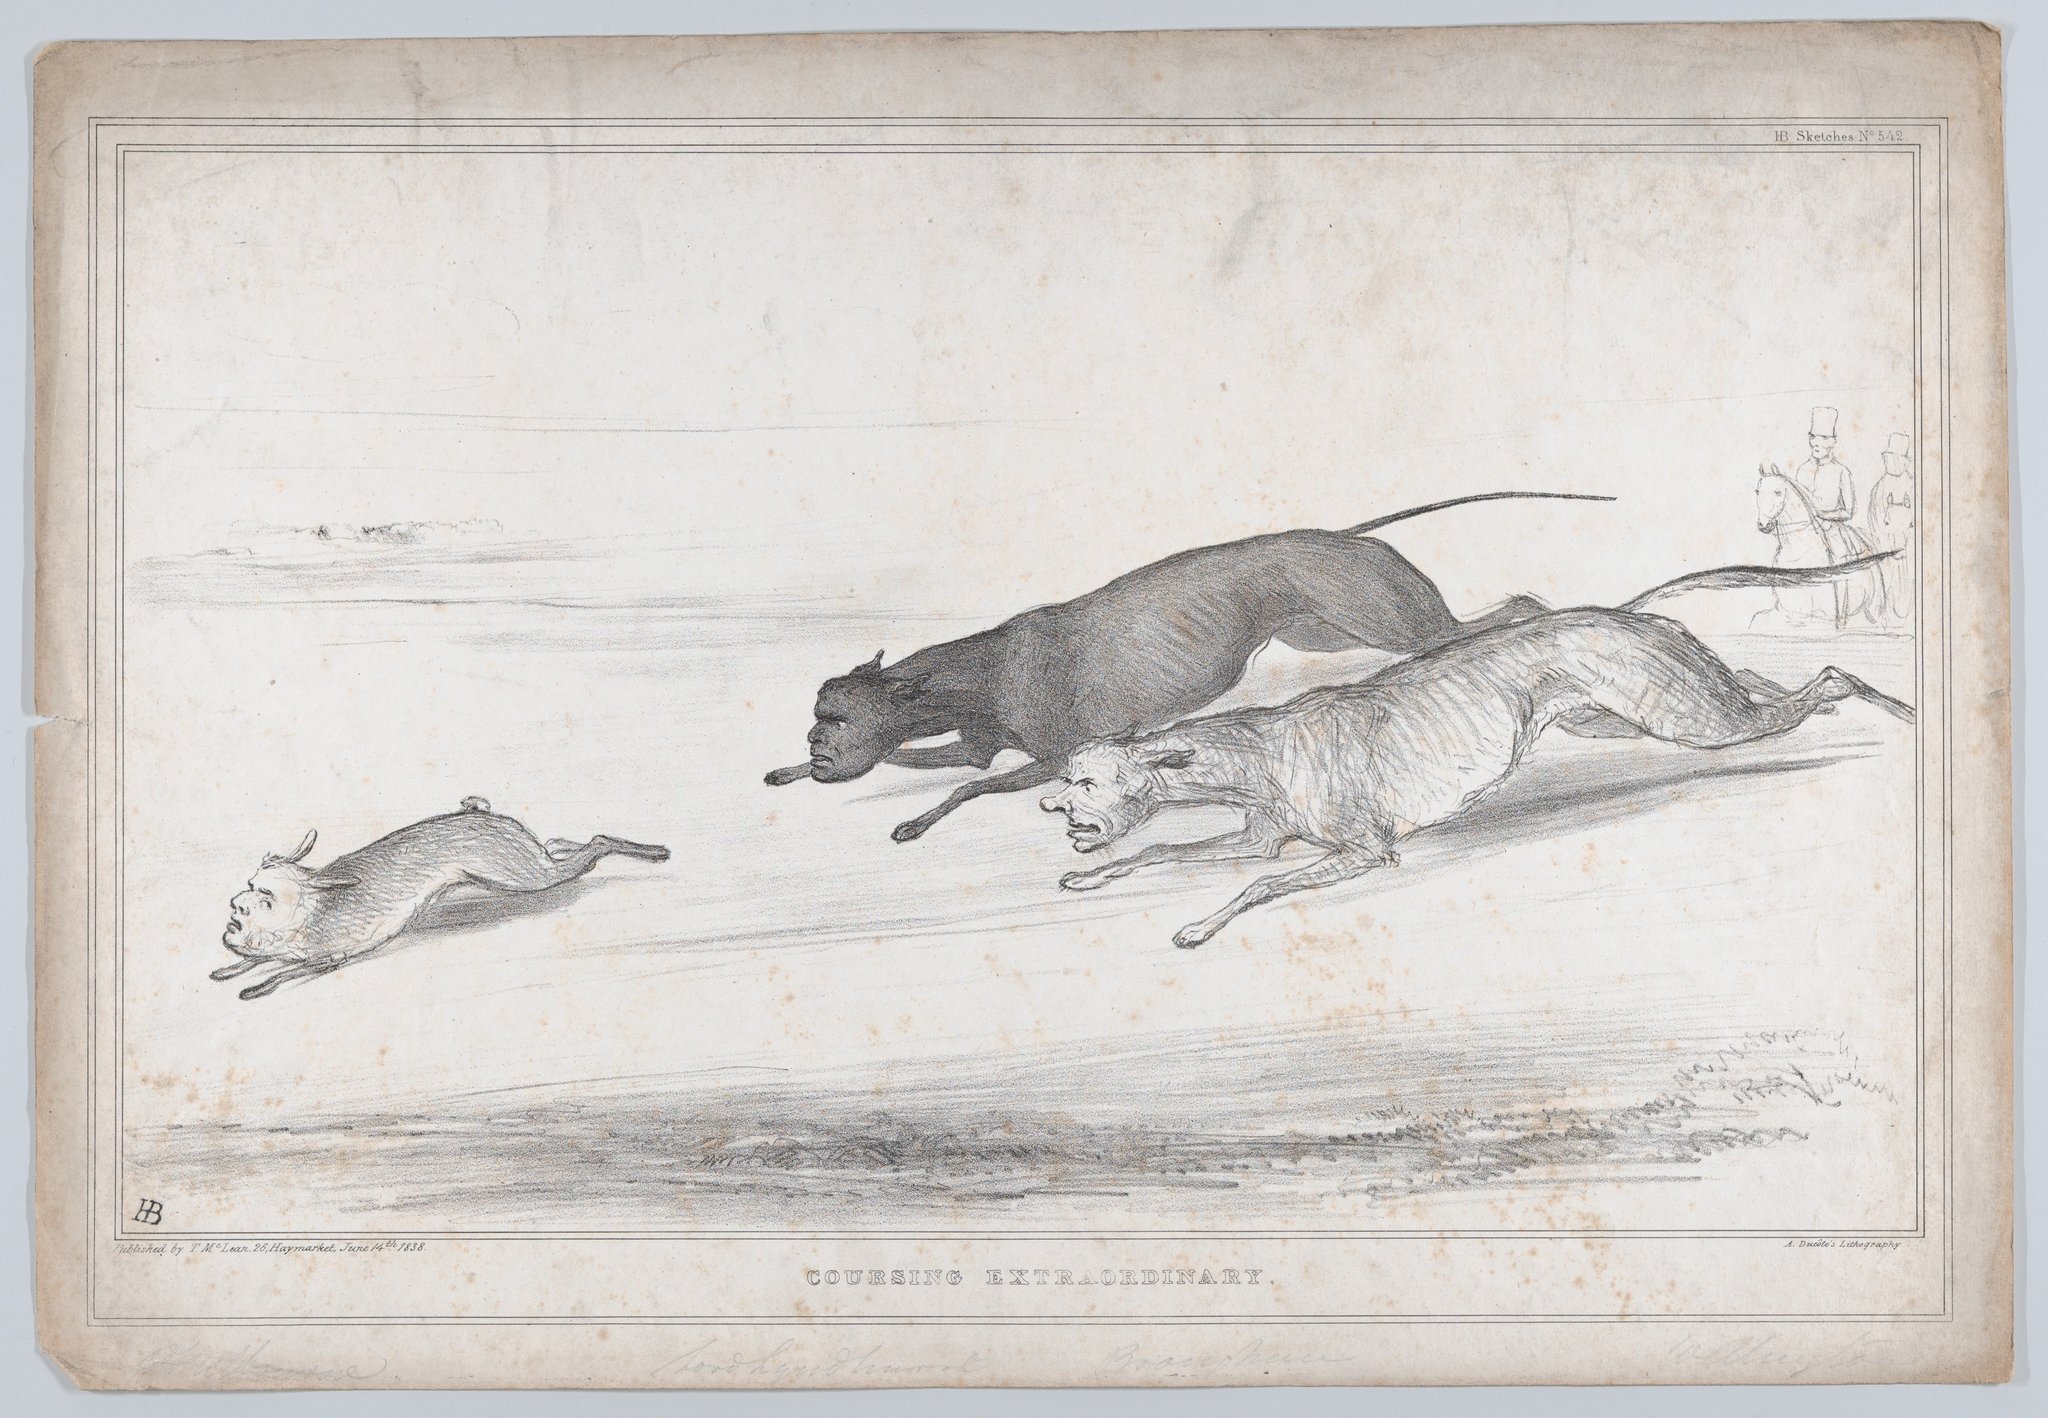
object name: print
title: Coursing Extraordinary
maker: john doyle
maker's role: artist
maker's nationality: irish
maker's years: 1797-1868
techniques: lithograph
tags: animals,dogs,caricature